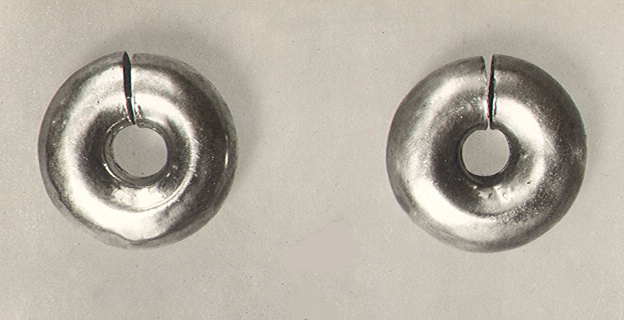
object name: earring, pennanular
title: Pair of Earrings (with 16.10.417)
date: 1635-1458 BCE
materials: gold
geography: egypt